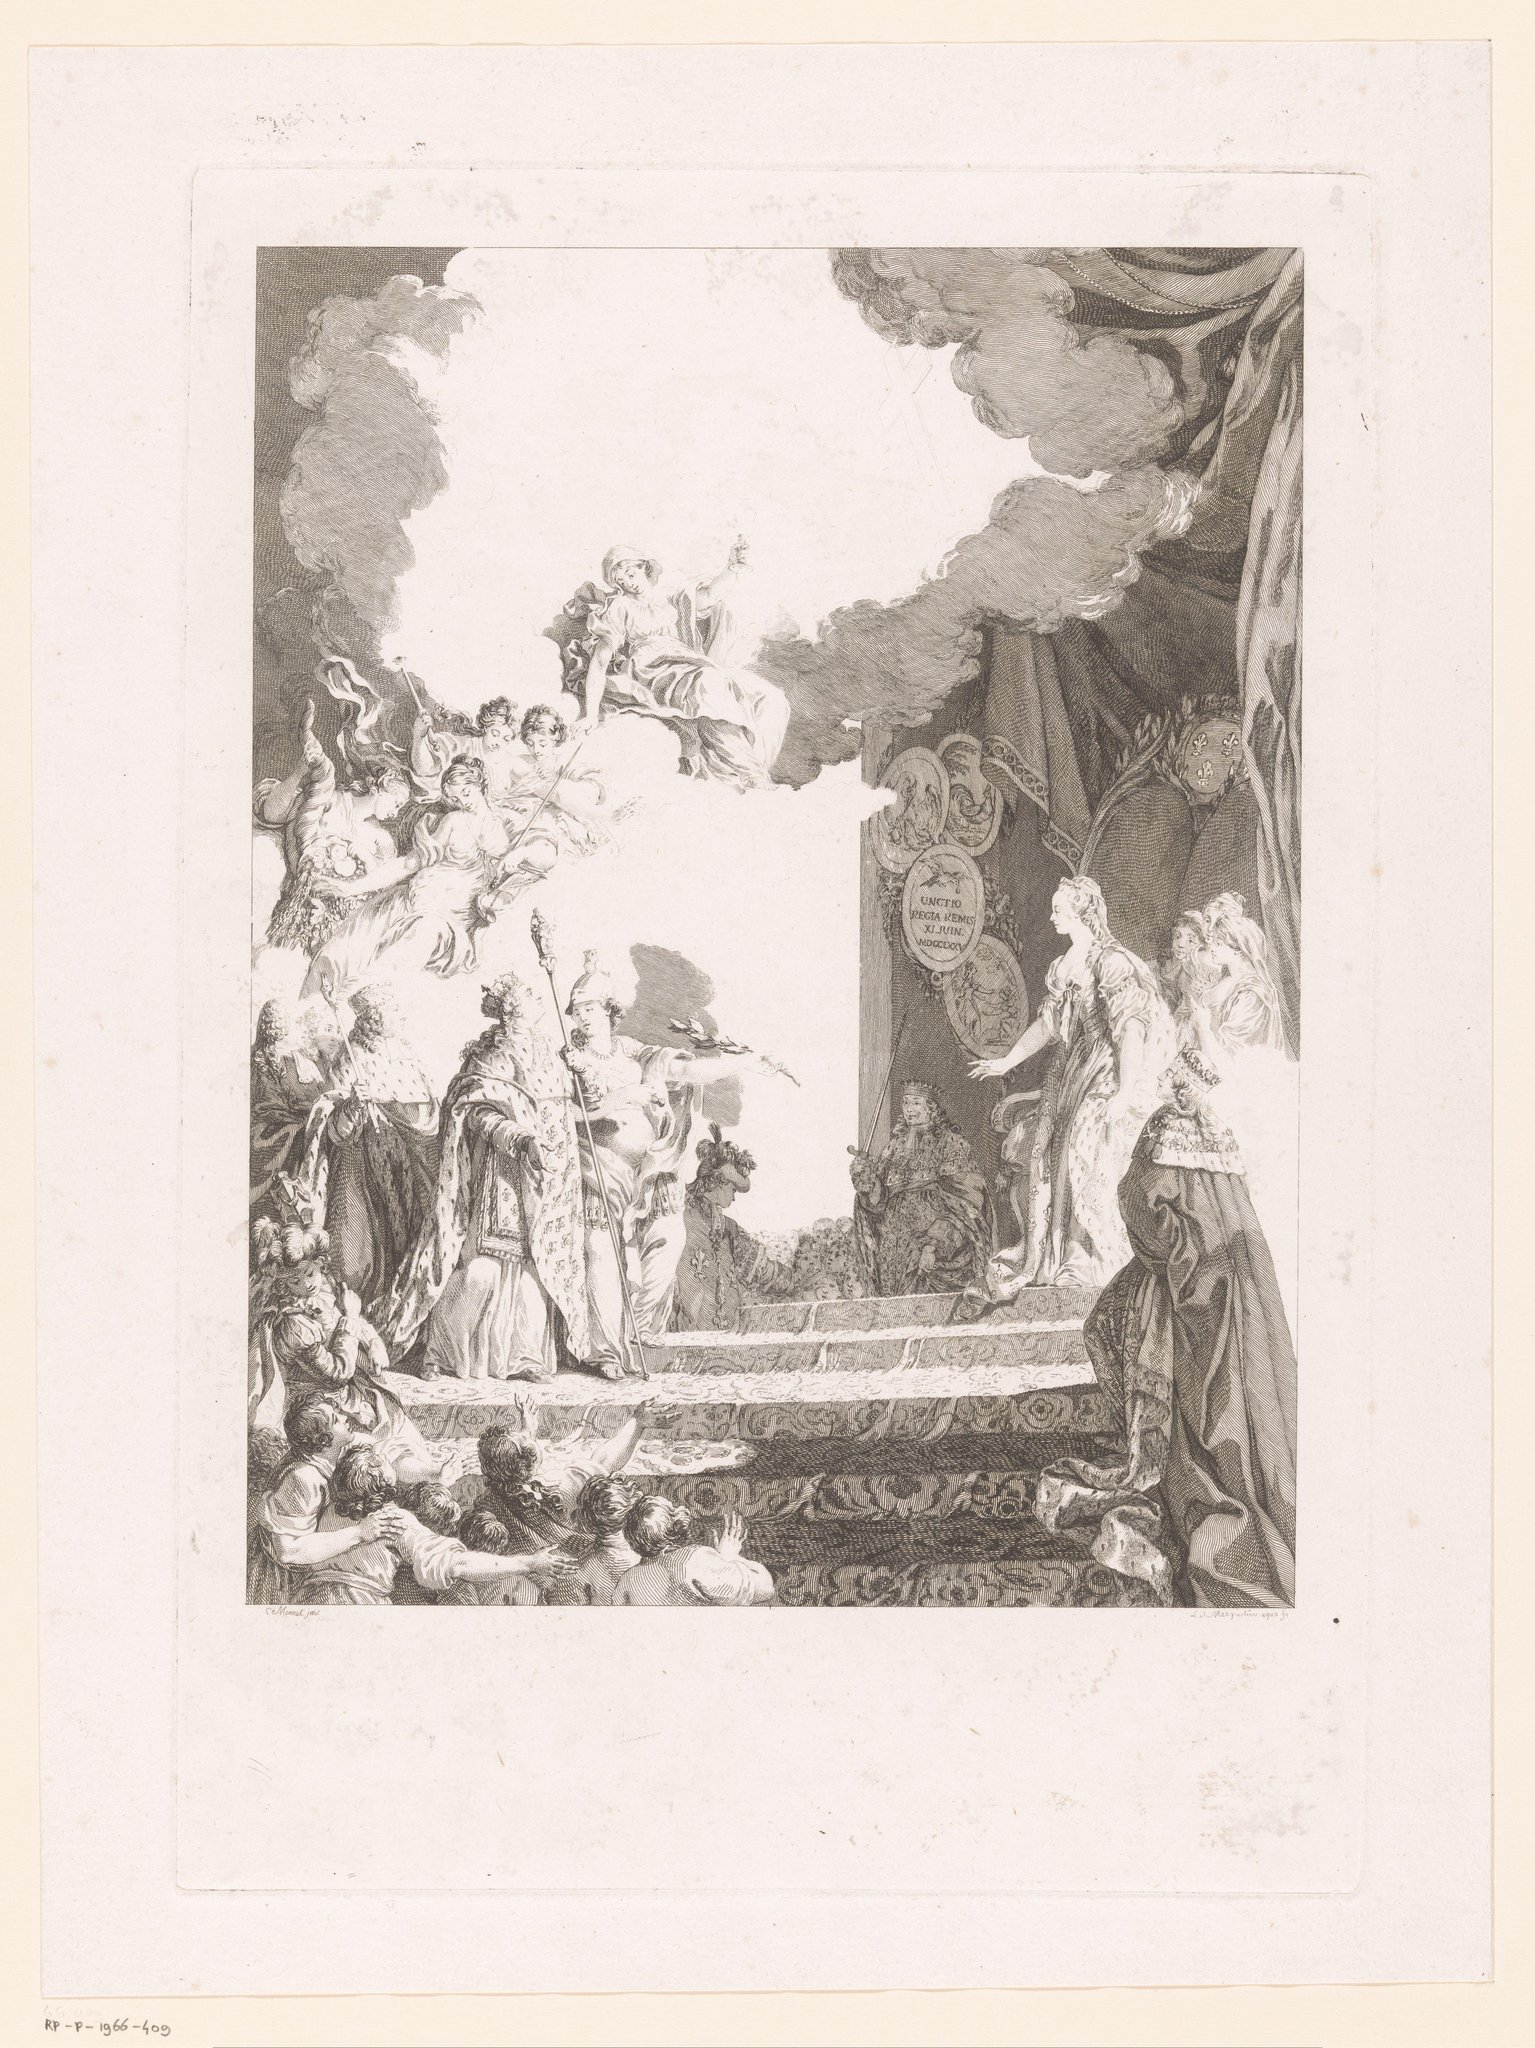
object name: print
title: Allegorie op de kroning van Lodewijk XVI op 11 juni 1775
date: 1751-1811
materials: paper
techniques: etching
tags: paris, lodewijk xvi (koning van frankrijk), marie antoinette, historical persons, coronation of a ruler, king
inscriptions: inscription: ‘1062-’, number: ‘403’, collector's mark: Lugt 2228